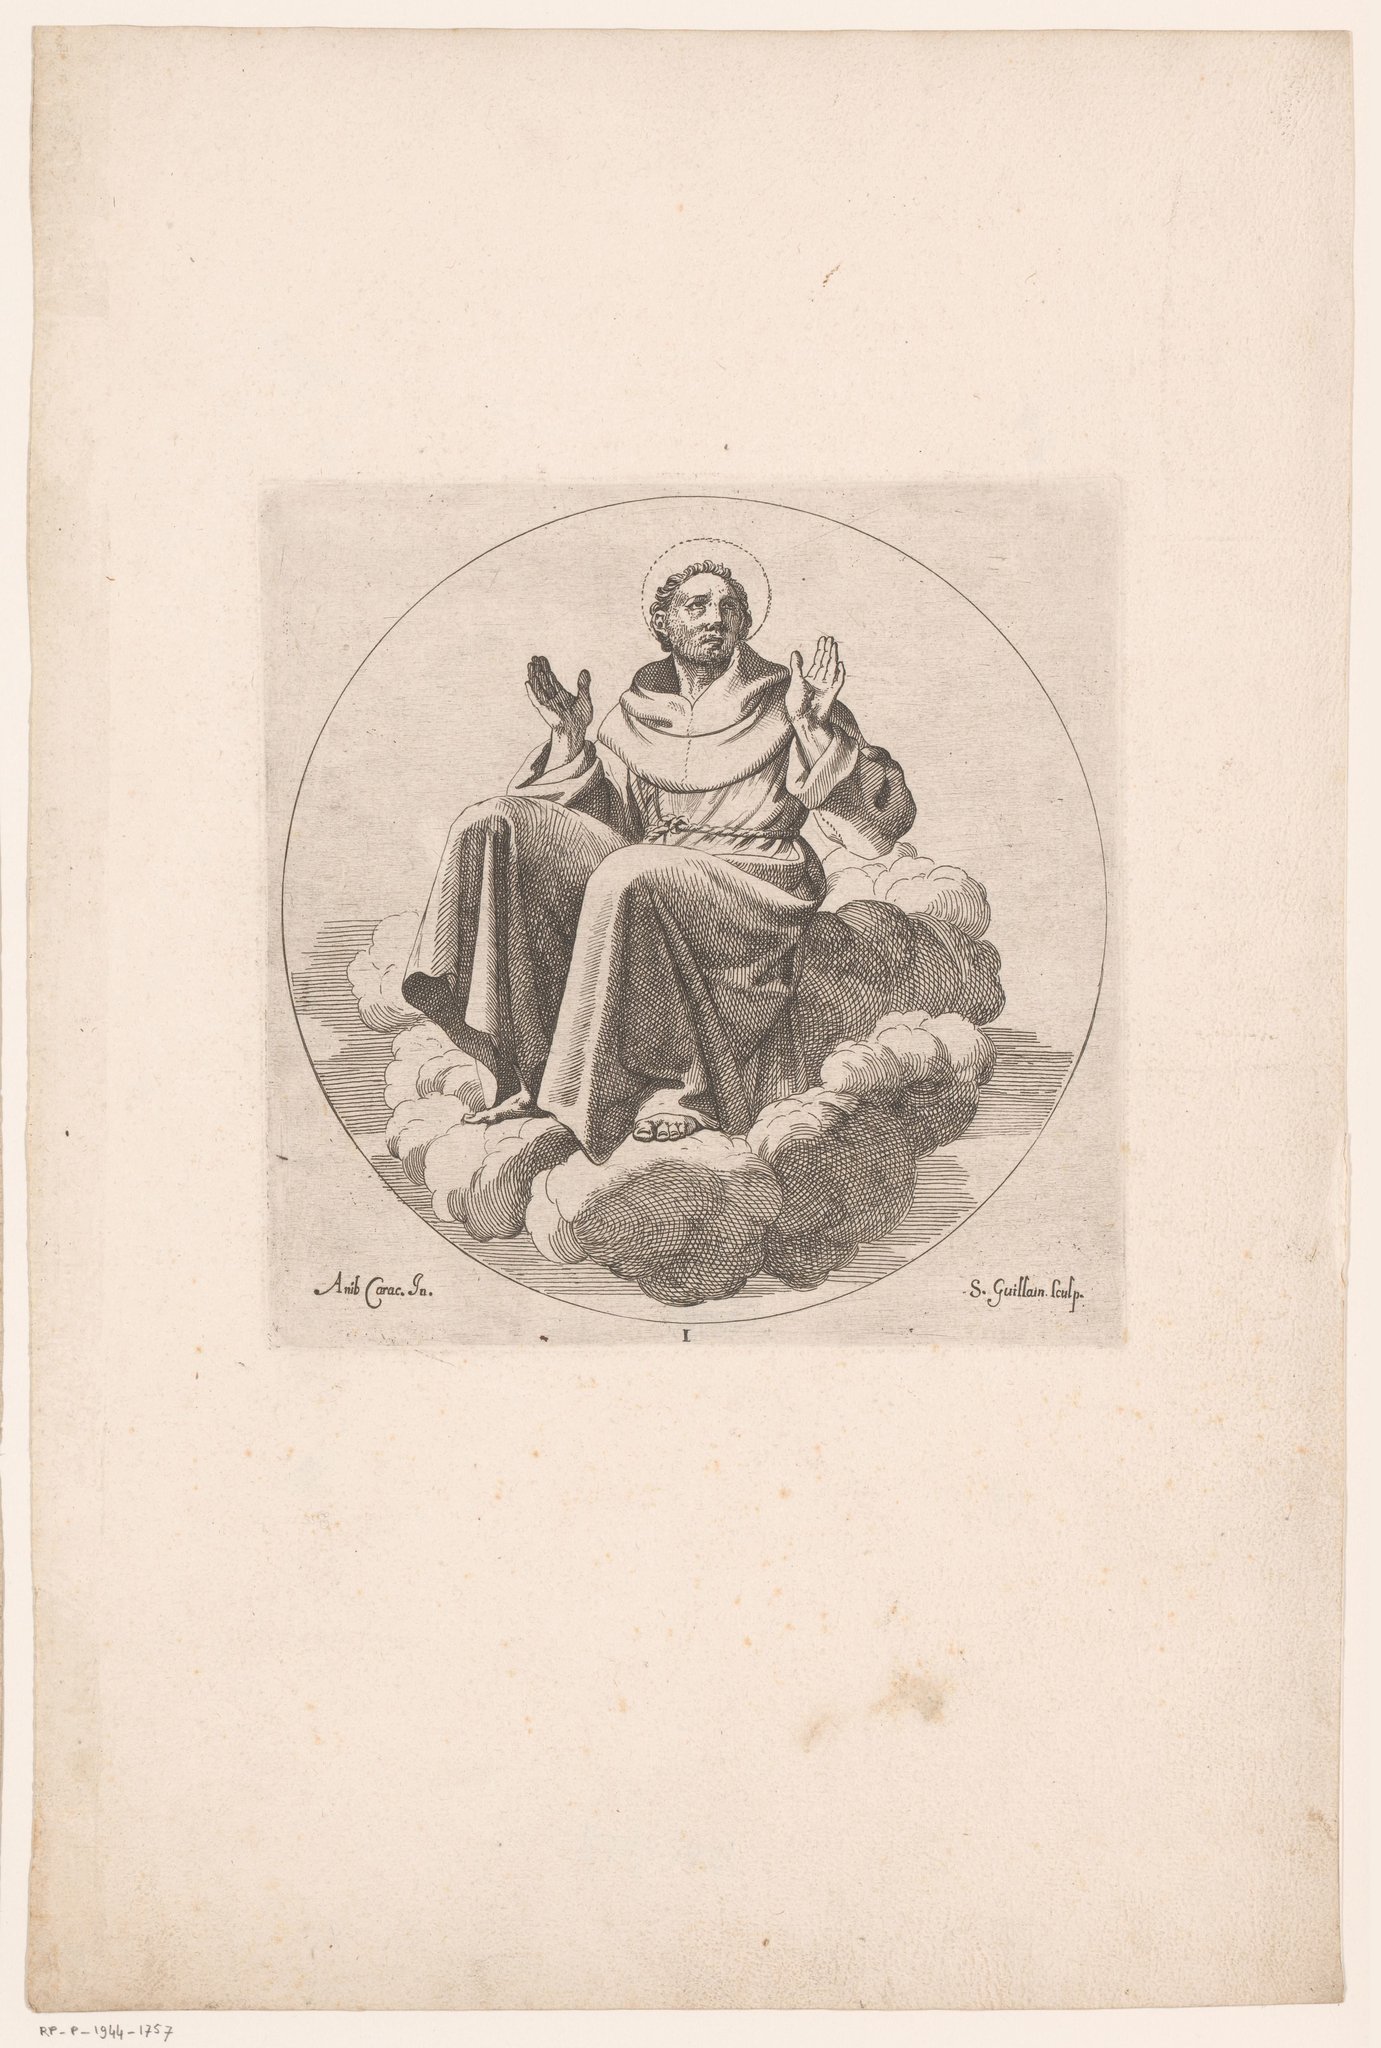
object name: print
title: Portret van Franz Georg von Schönborn, aartsbisschop en keurvorst van Trier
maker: johann martin bernigeroth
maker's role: print maker, publisher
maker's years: 1713-1767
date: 1742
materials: paper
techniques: engraving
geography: leipzig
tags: historical persons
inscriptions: collector's mark: Lugt 2228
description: Prent ook gebruikt in: Die Neue Europäische Fama, Welche den gegenwärtigen Zustand der vornehmsten Höfe entdecket. dl. 83. Leipzig: Gleditsch, 1742.